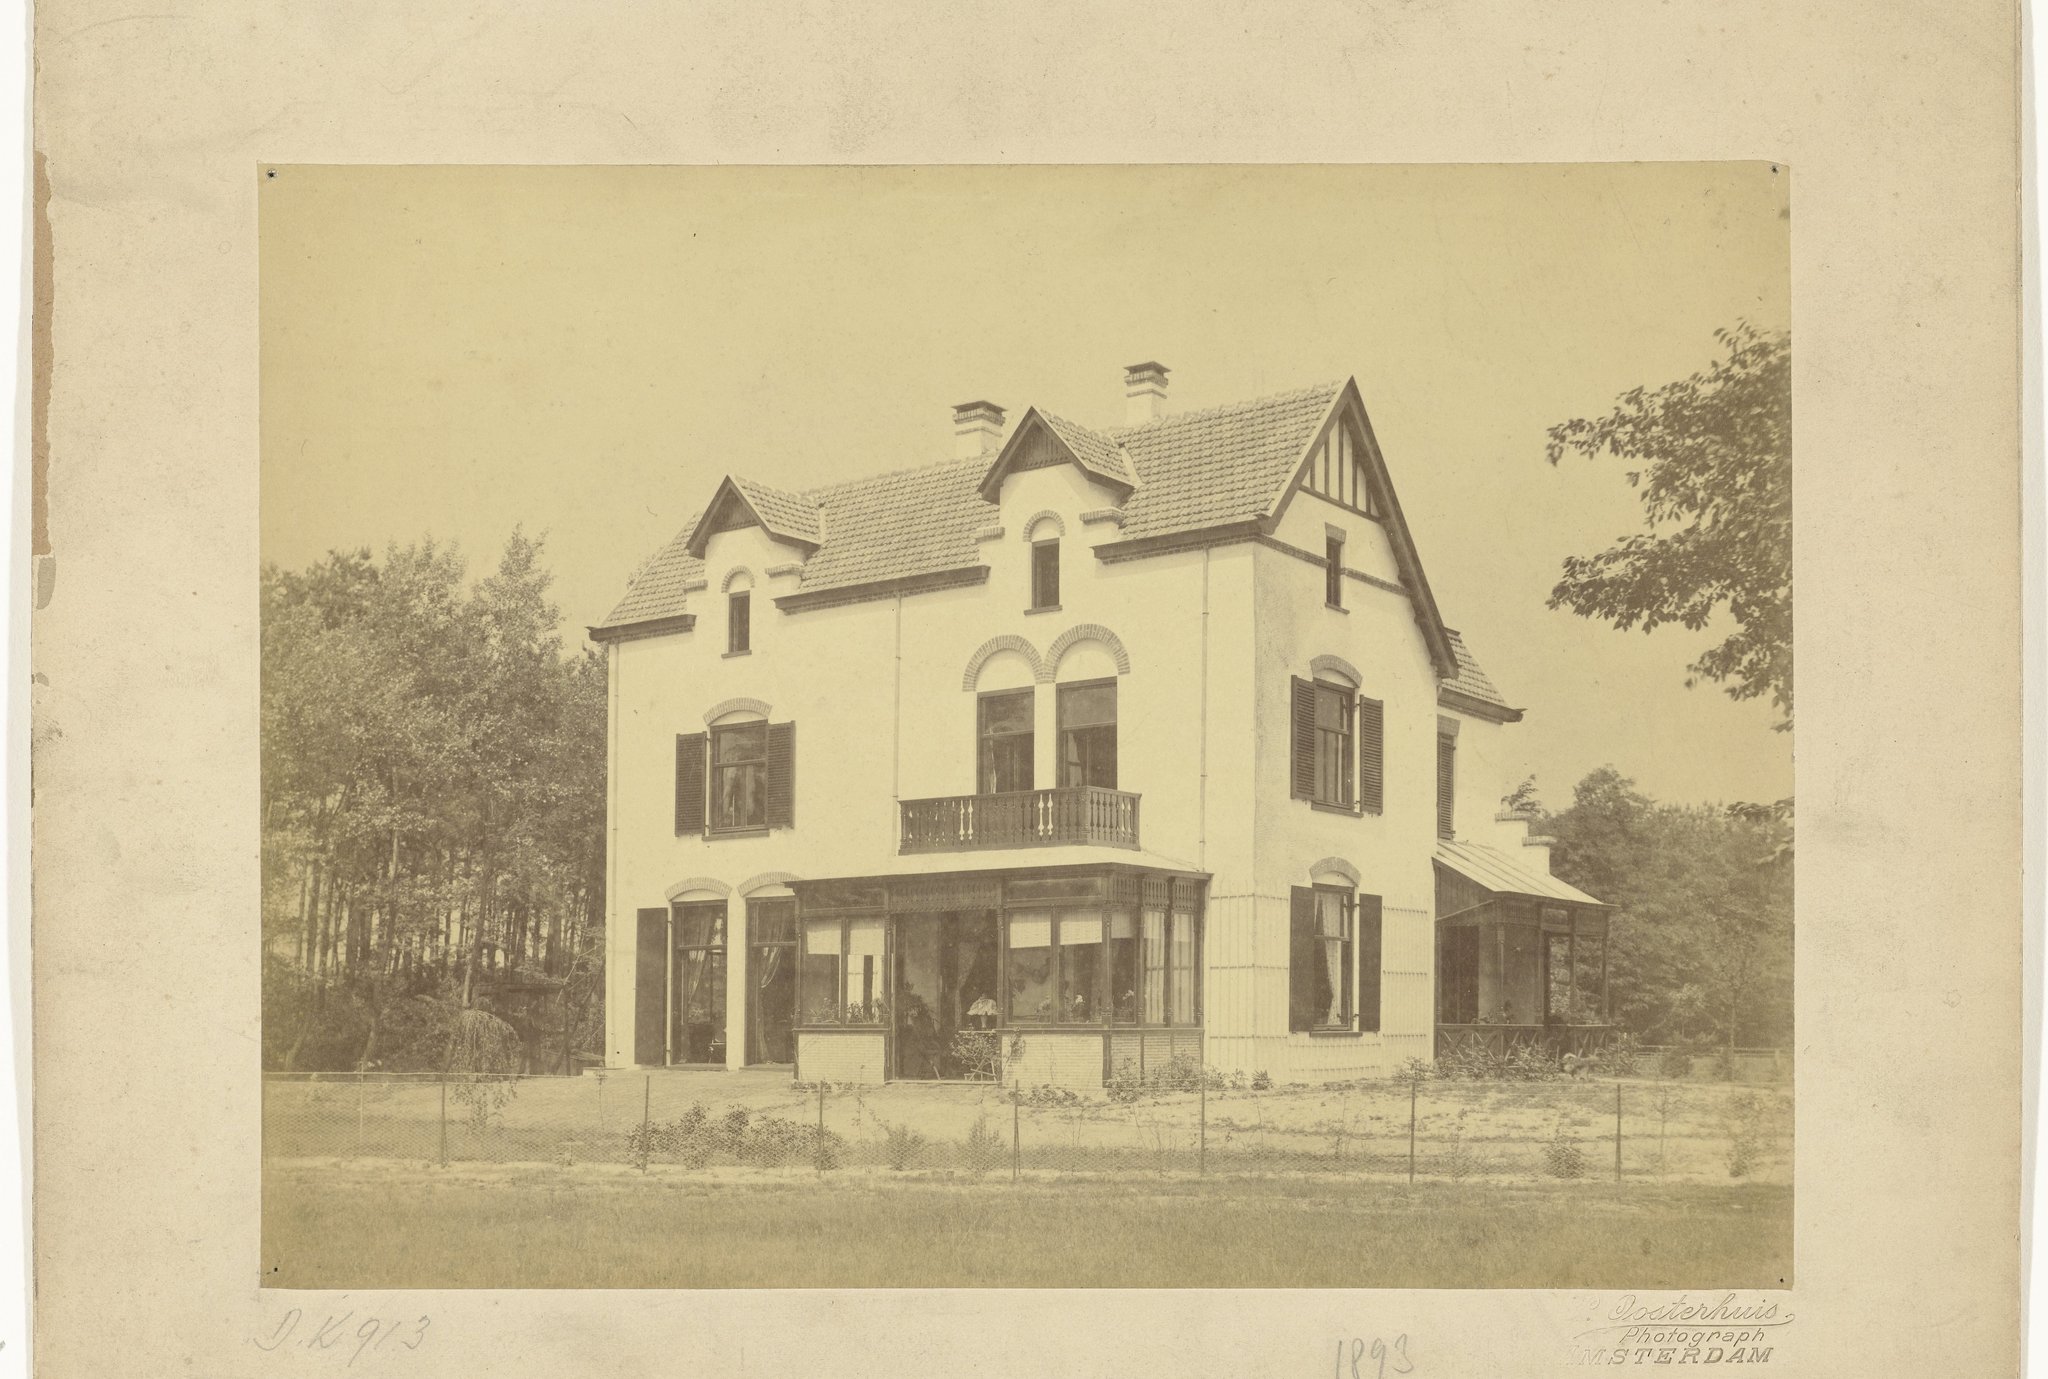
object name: photograph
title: Huis D. van Eedenm, huis in Bussum (Holland) archt. H.P. Berlage Amsterdam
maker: pieter oosterhuis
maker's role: draughtsman, print maker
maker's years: 1816-1885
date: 1893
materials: cardboard, paper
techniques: albumen print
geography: amsterdam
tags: villa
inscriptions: check stamp: ‘P. Oosterhuis Photogr. Amsterdam’, number: ‘194/18’